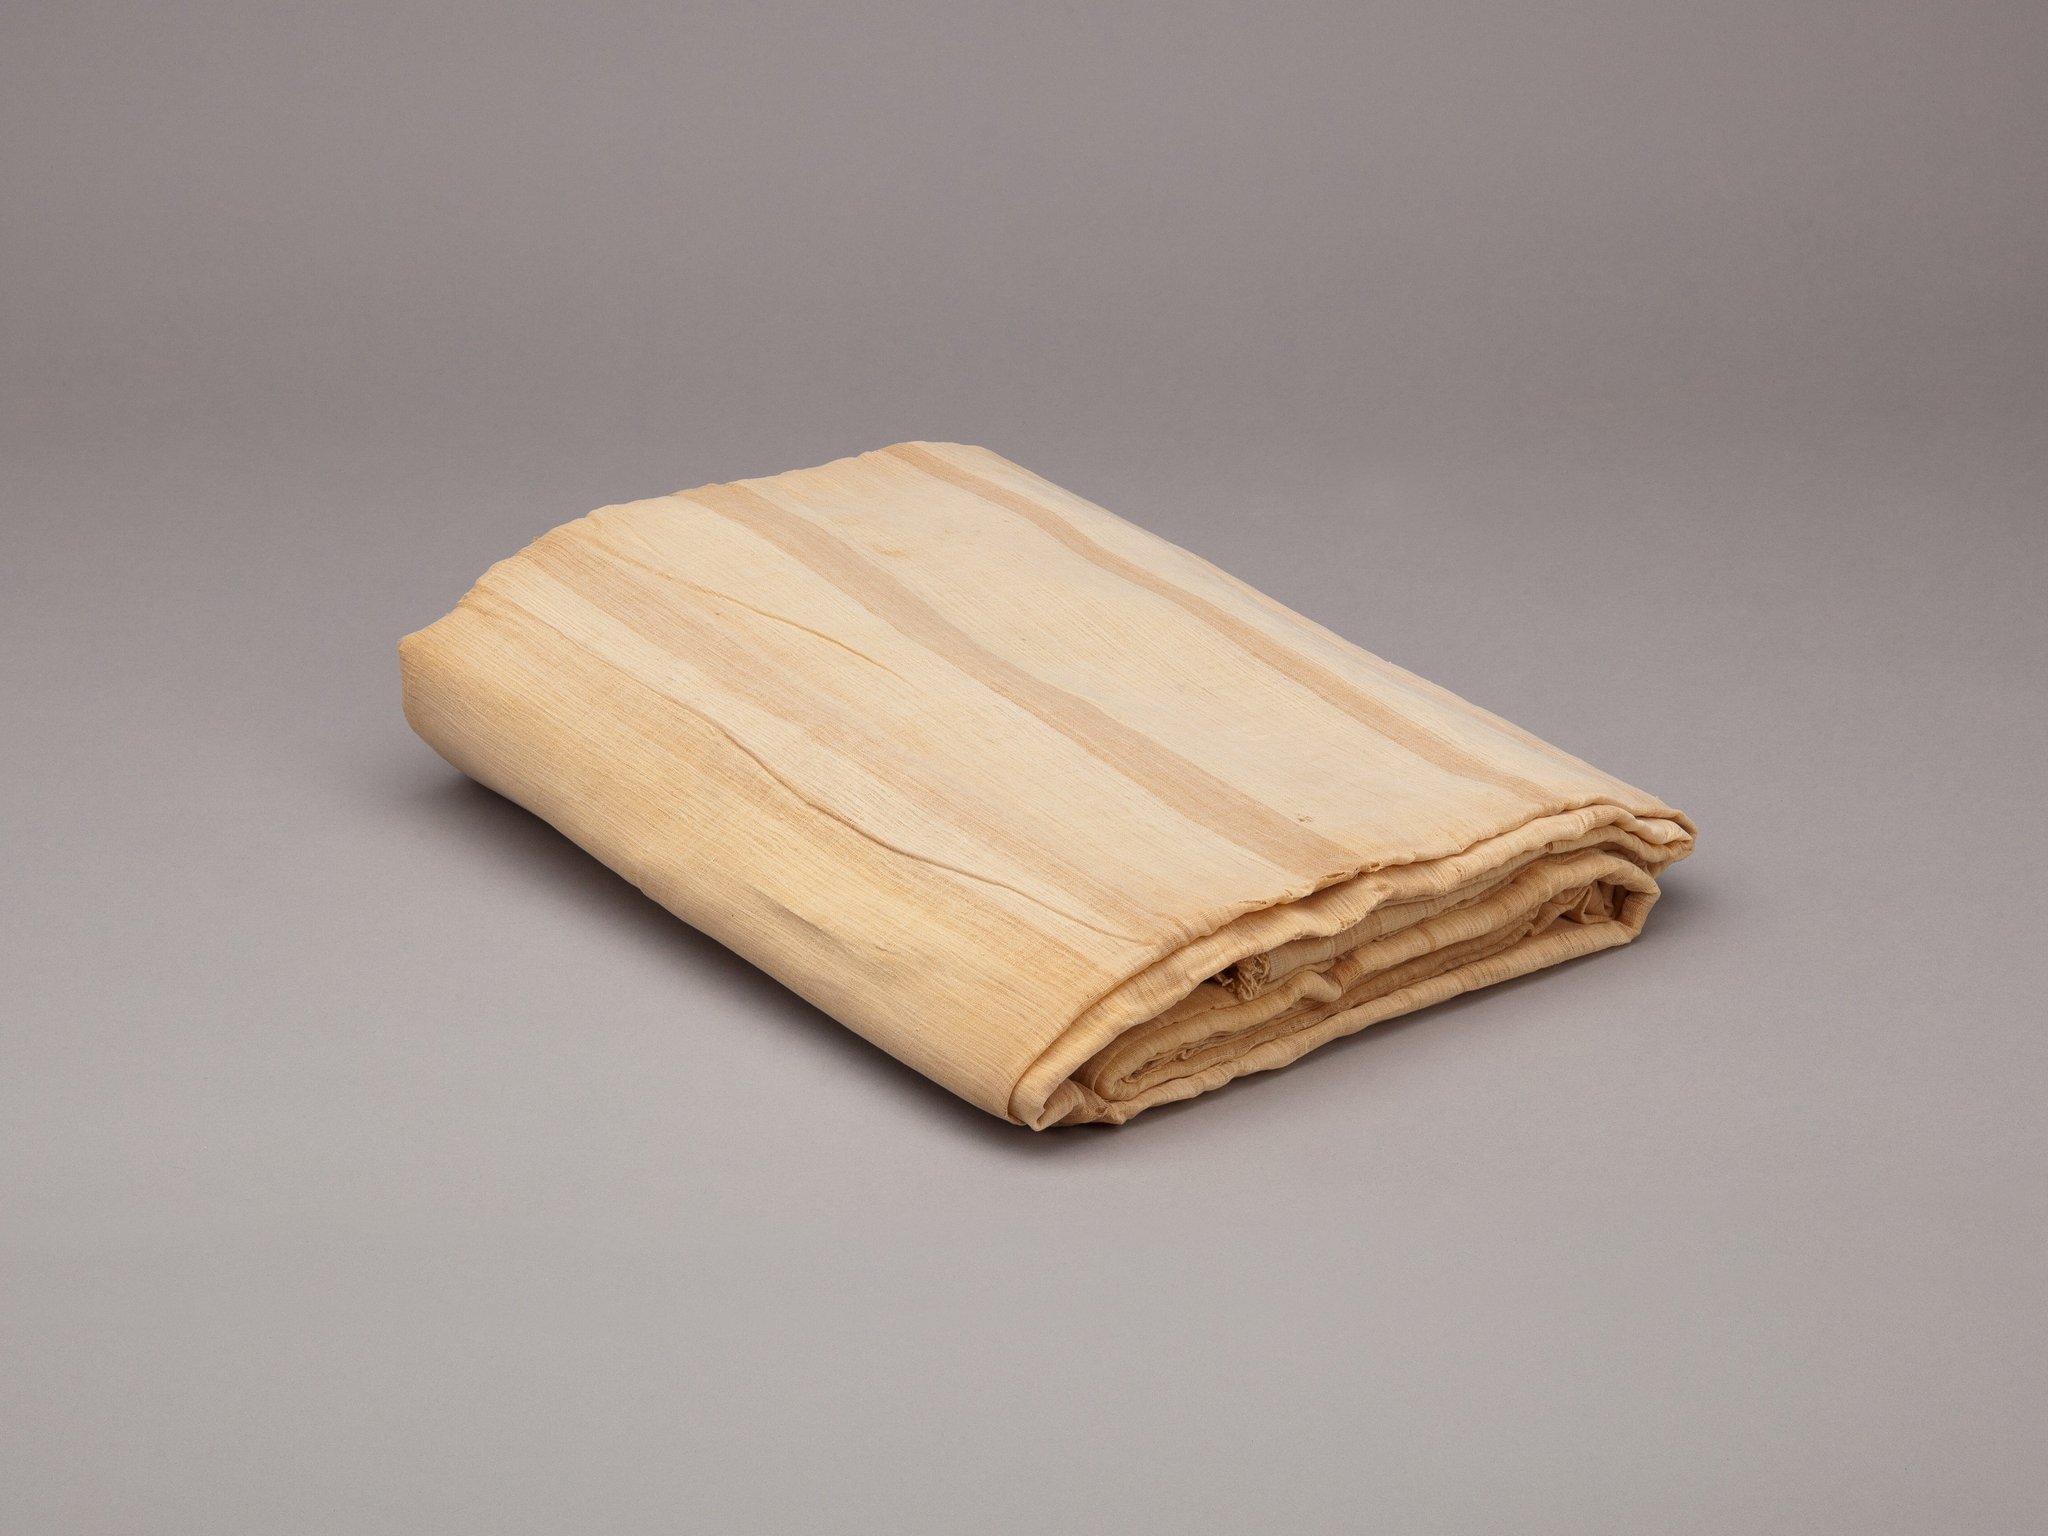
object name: linen mark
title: Sheet, linen mark, fine spin, close weave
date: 1492-1473 BCE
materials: linen, wax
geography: egypt